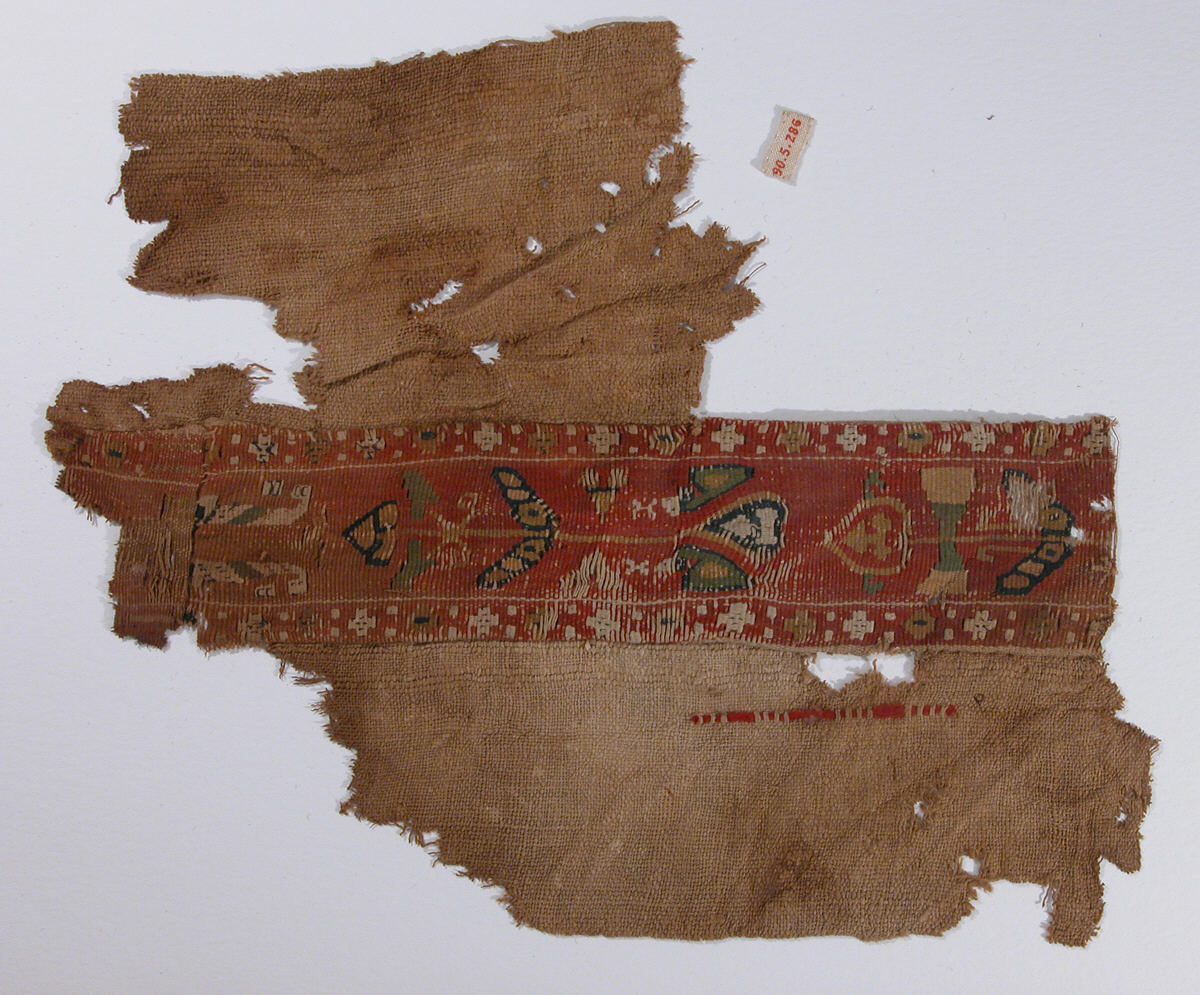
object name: textile fragment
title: Fragment of a Tunic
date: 501-600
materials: linen, wool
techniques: weave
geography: egypt